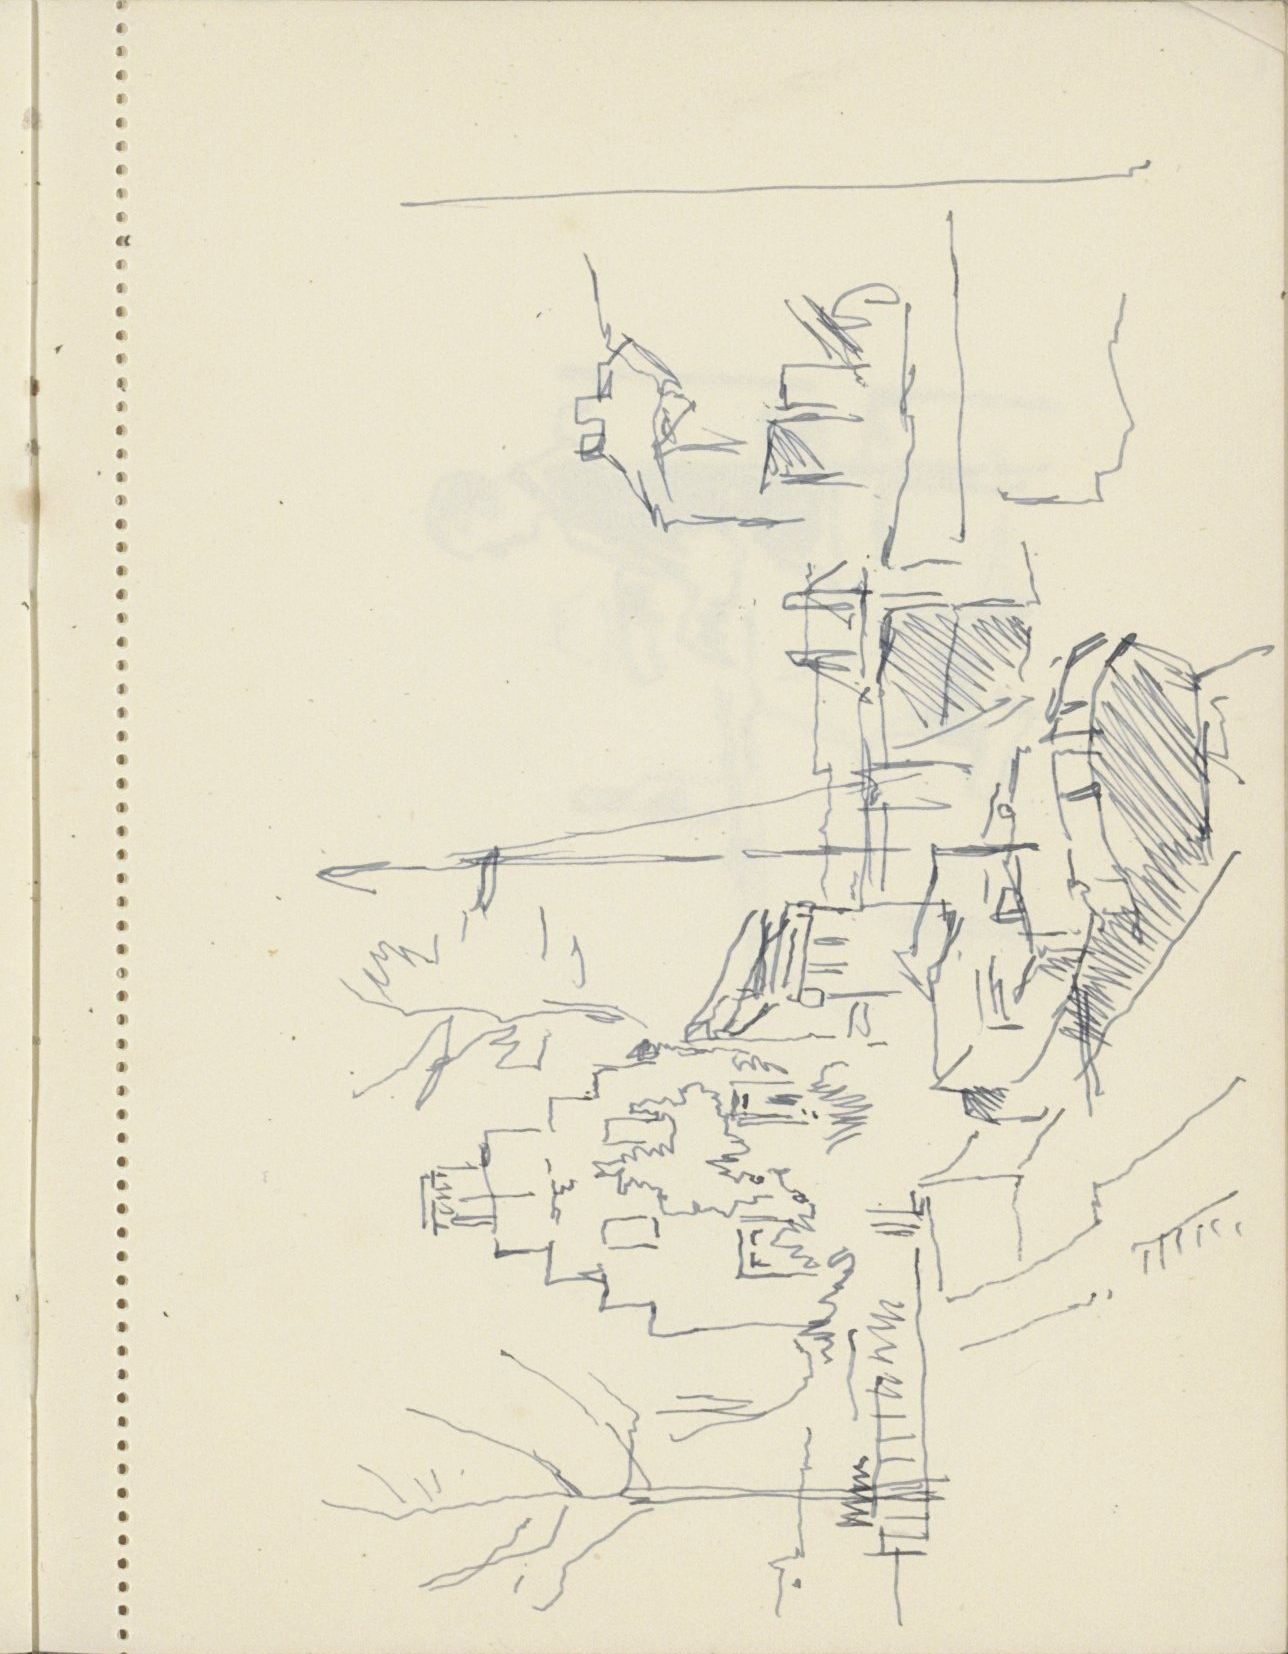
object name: sketchbook leaf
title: Gracht met een aangemeerde zeilboot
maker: cornelis vreedenburgh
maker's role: draughtsman, print maker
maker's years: 1880-1946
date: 1890-1946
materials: ink, paper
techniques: pen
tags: sailing-ship, sailing-boat, canals, waters (in city)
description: Op de achtergrond huizen. Blad 32 recto uit een schetsboek met 71 bladen.